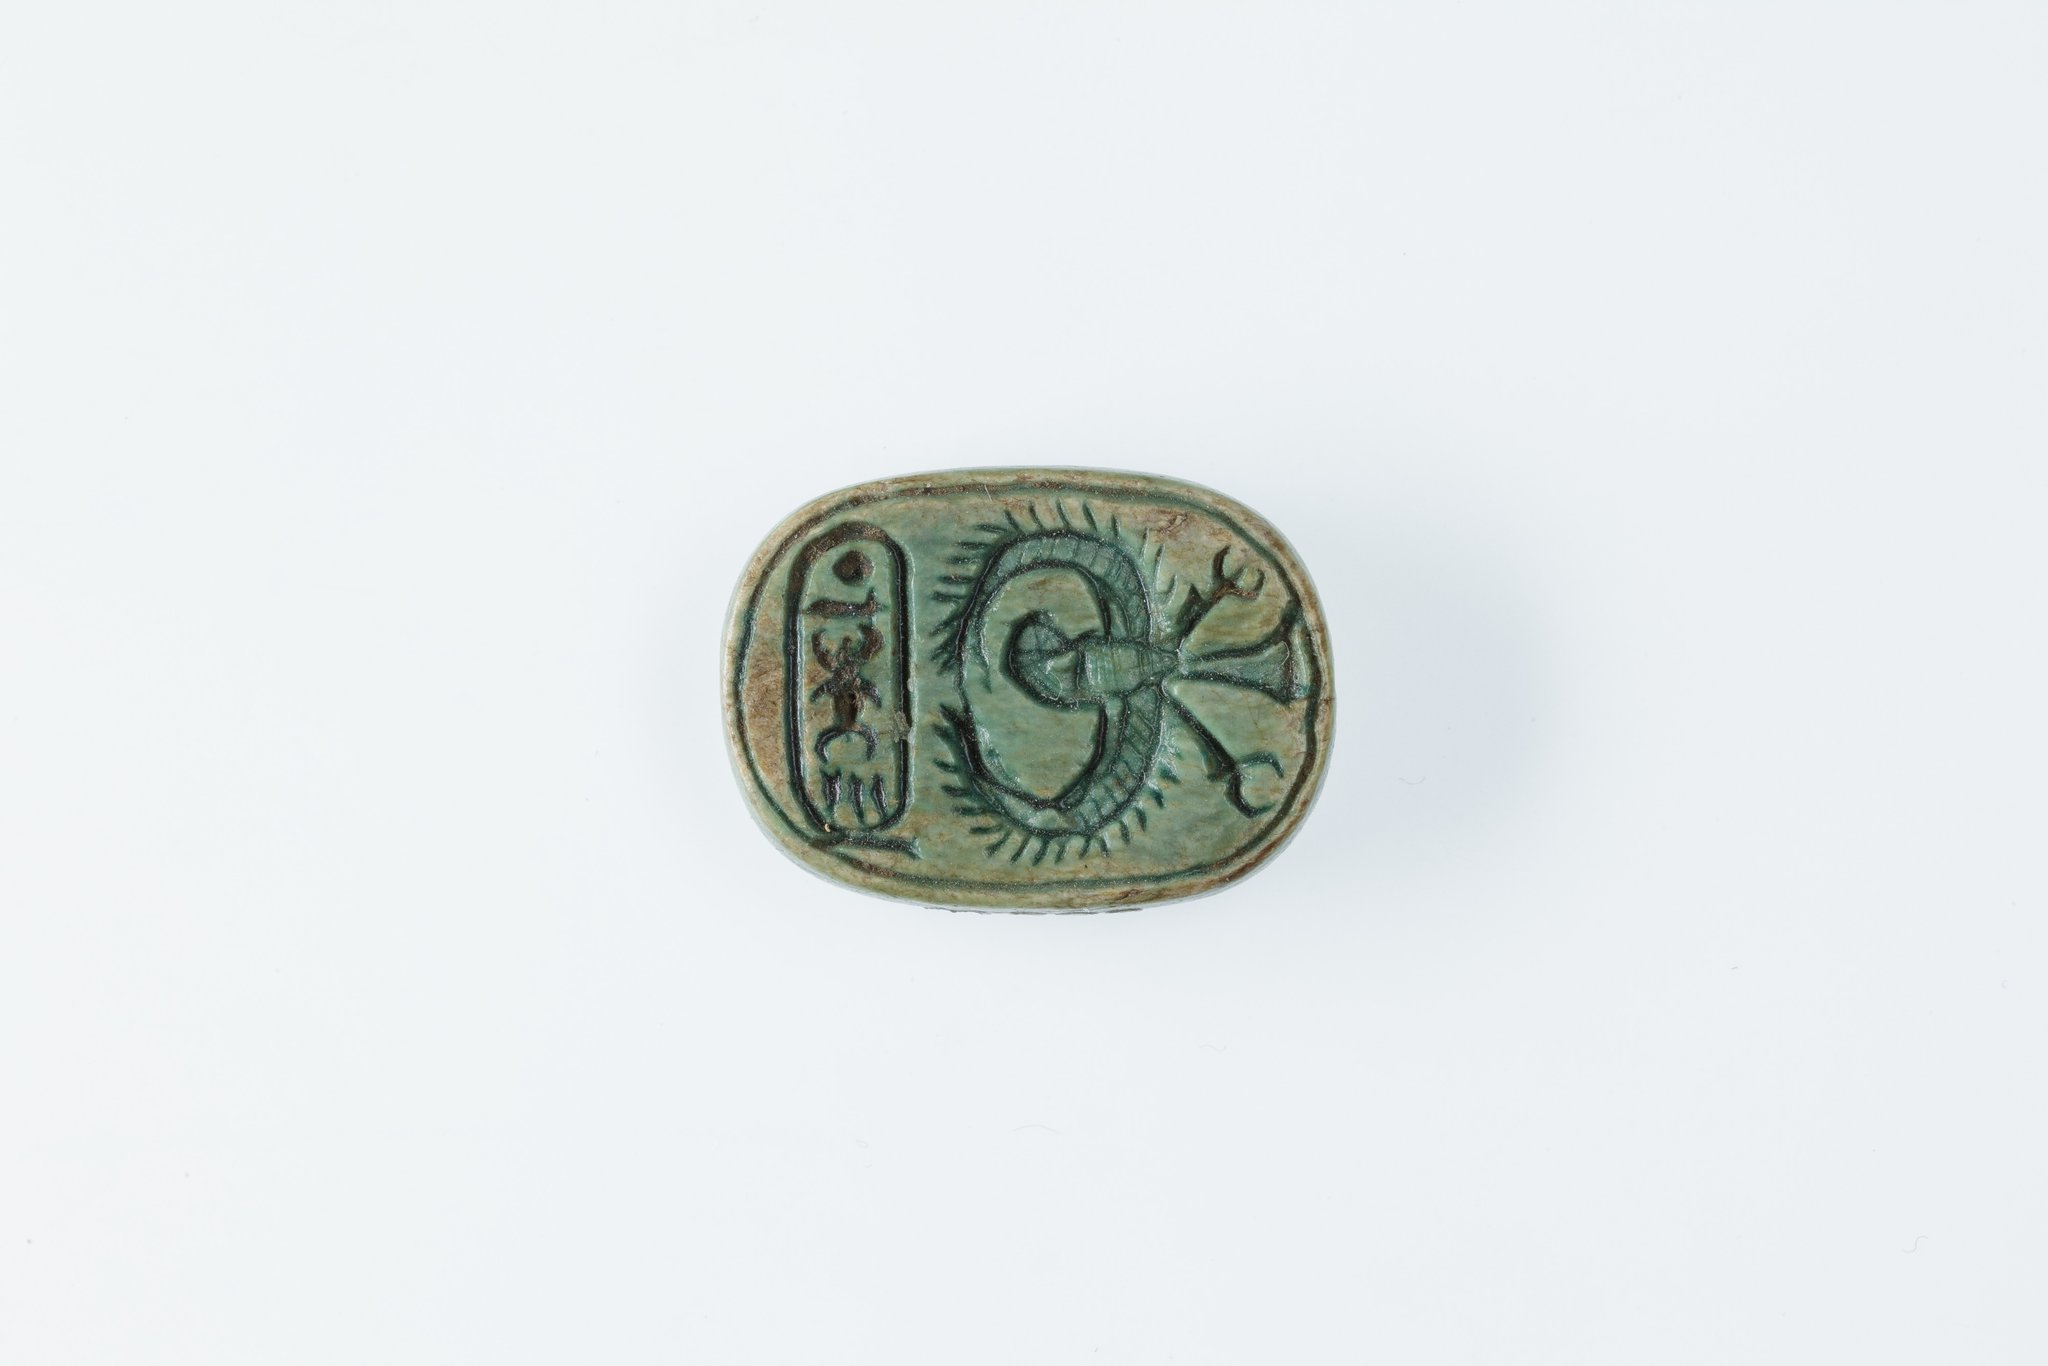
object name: plaque, amenhotep ii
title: Plaque Inscribed for Amenhotep II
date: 1427-1400 BCE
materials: stone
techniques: glazing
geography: egypt